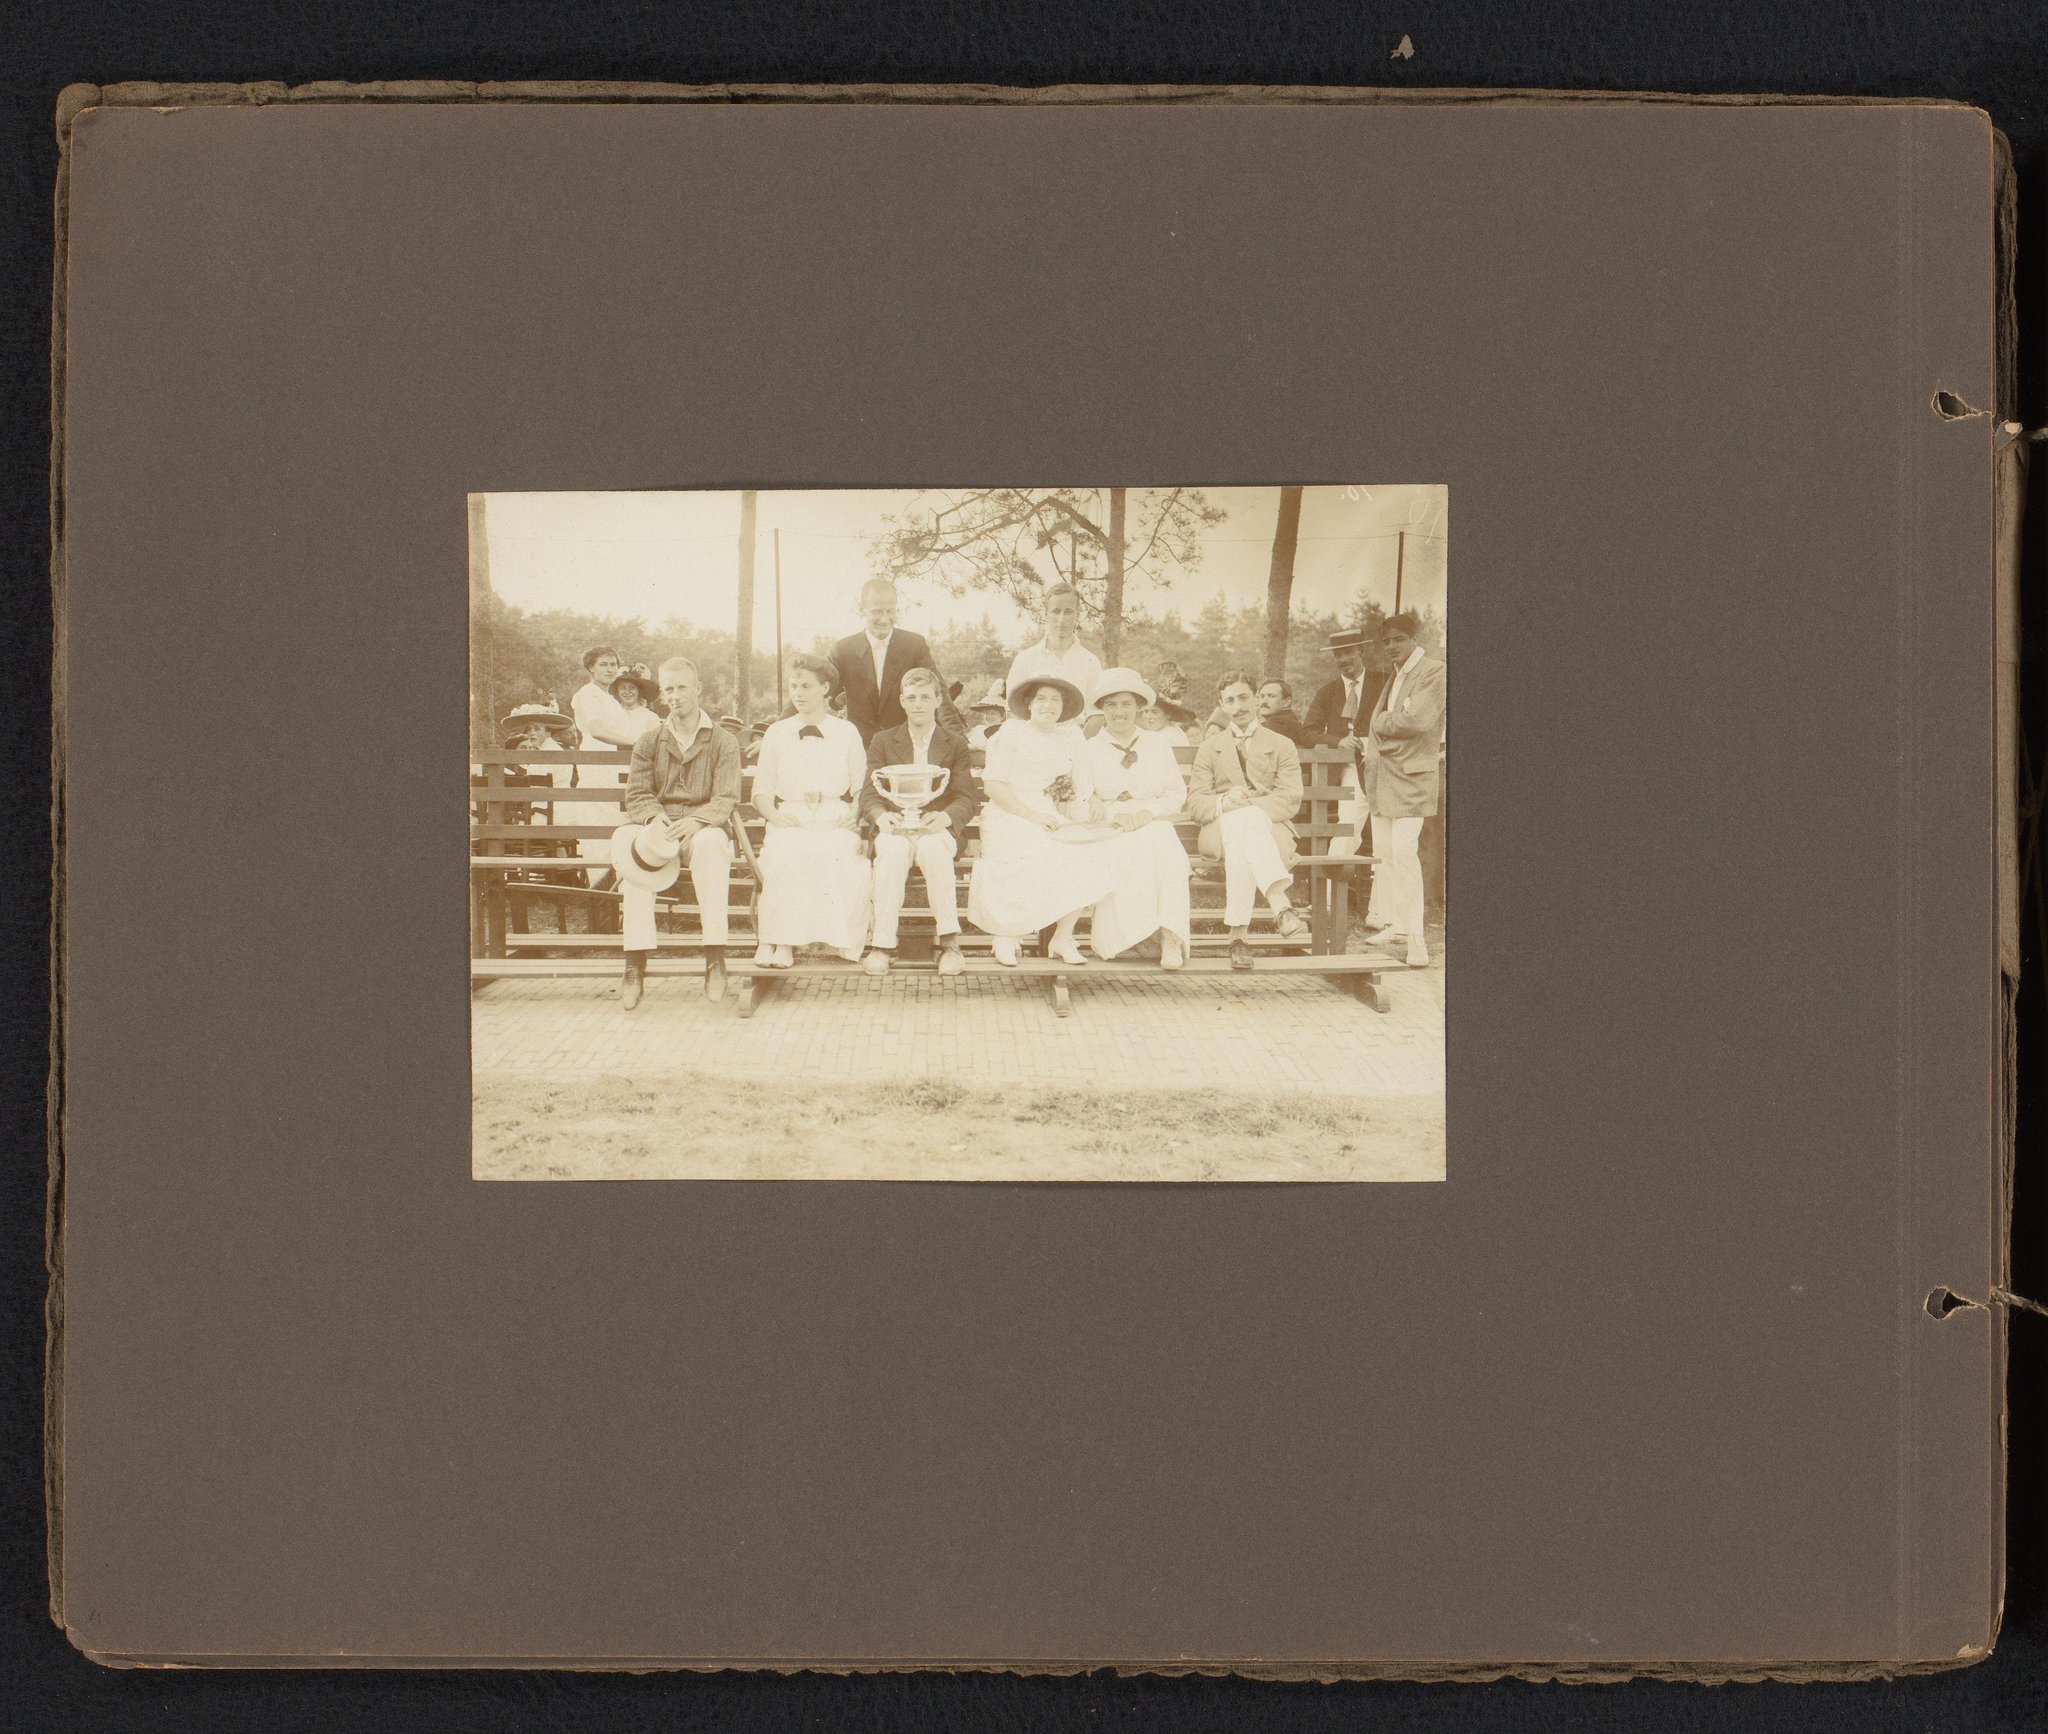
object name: album leaf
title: Groepsportret van Arthur Diemer Kool, Loes Everts en Dolly Blom en anderen bij de Nederlandse kampioenschappen tennis te Hilversum, 1912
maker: carolina frederika onnen (lien/loen)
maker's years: 1896-1983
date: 1912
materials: paper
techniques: gelatin silver print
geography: hilversum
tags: tennis, lawn-tennis, historical persons